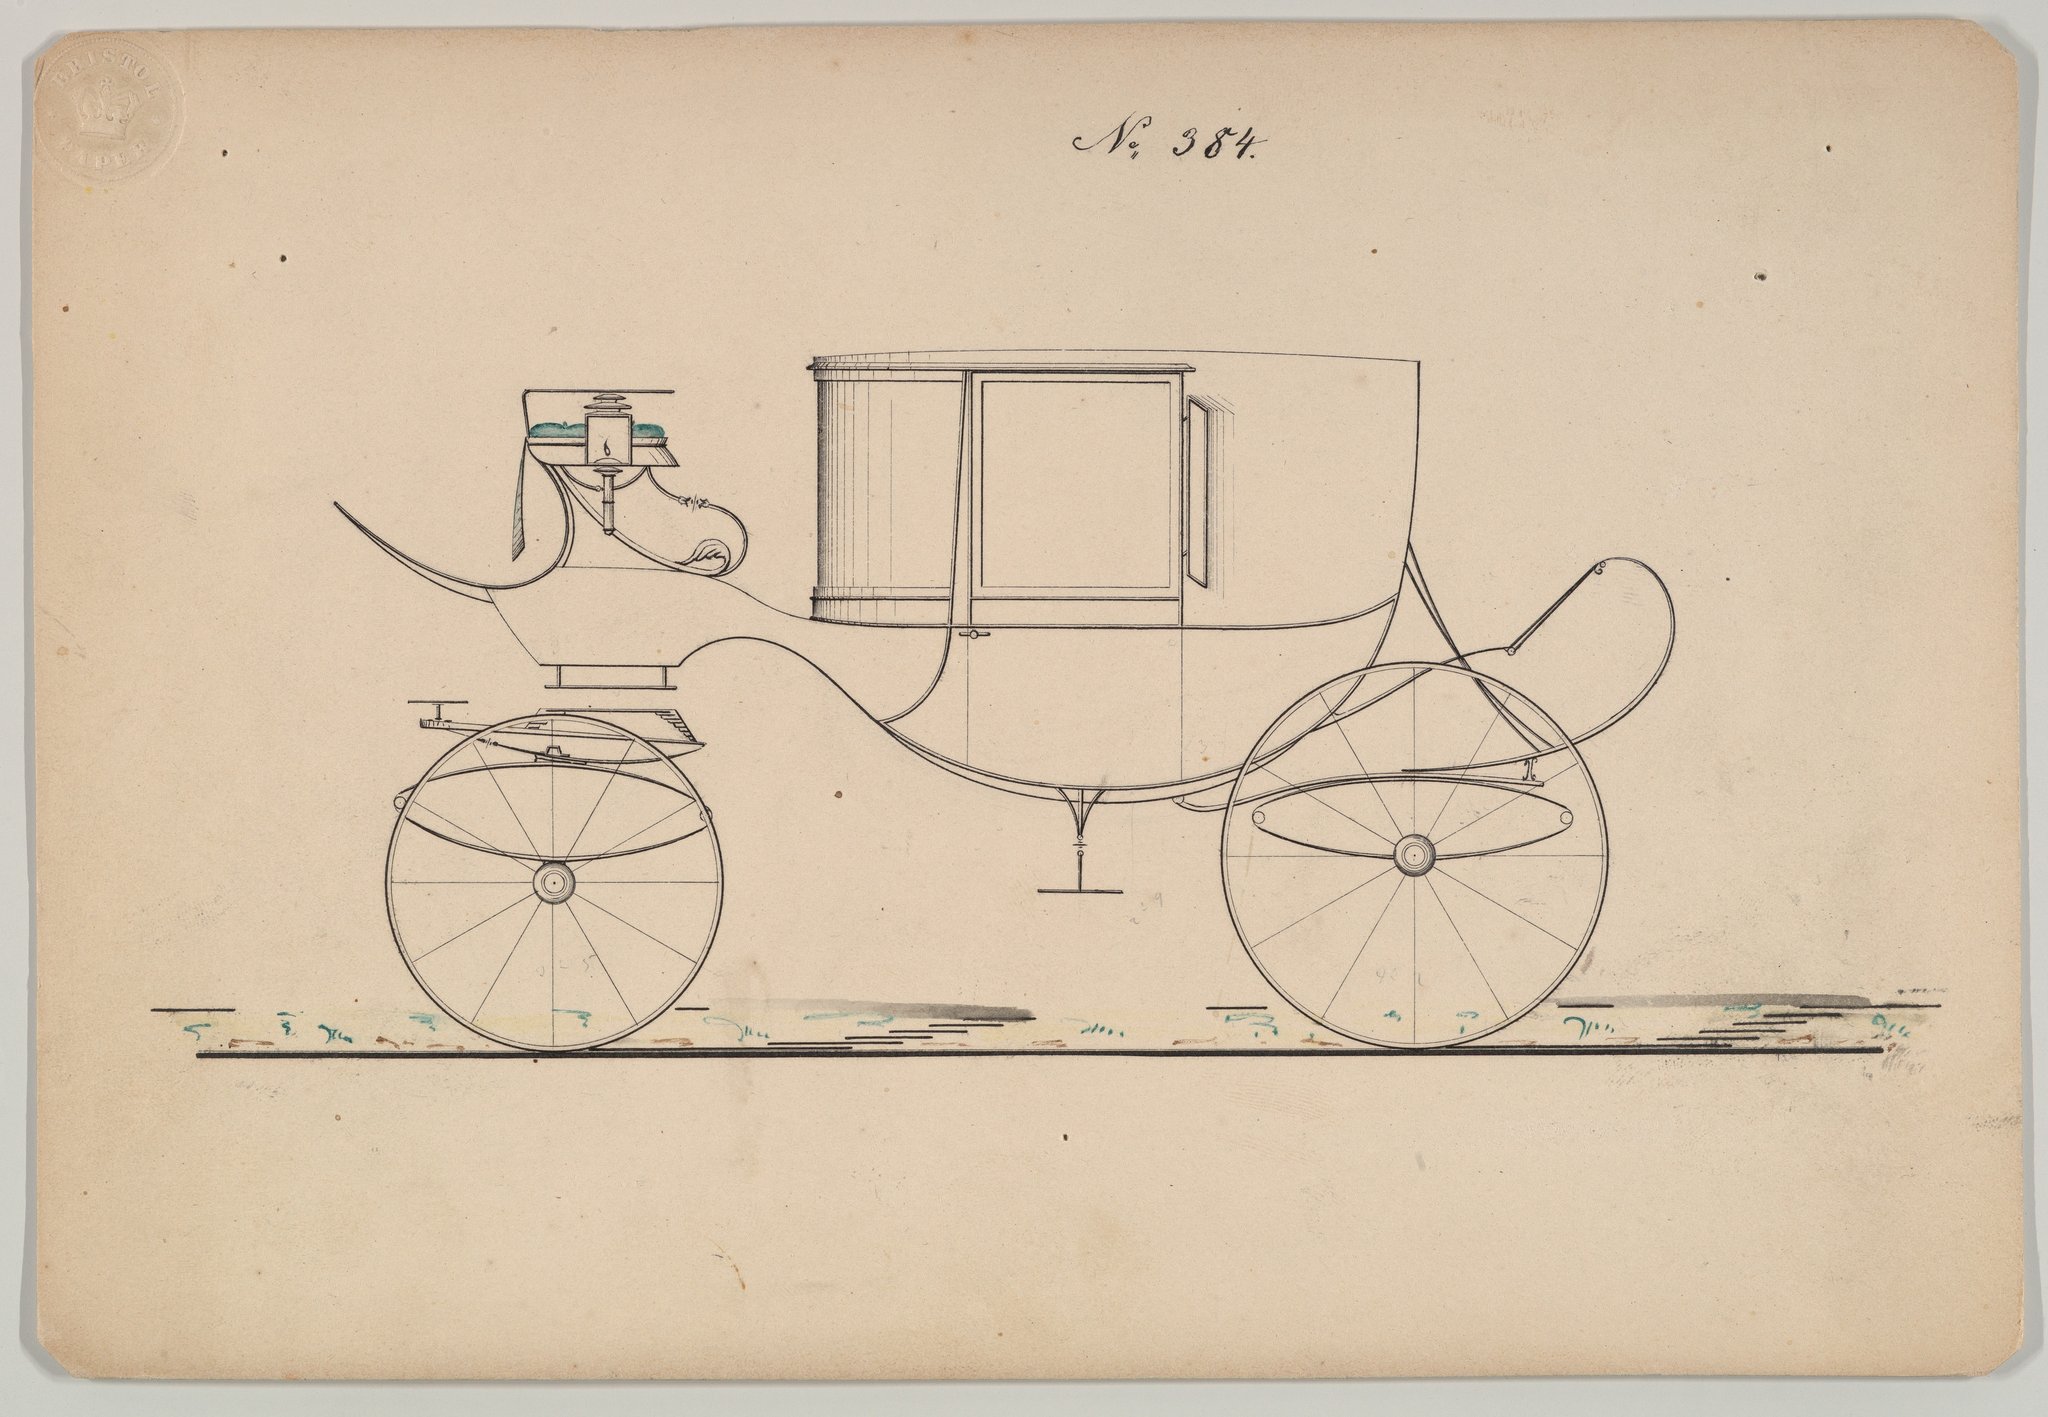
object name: drawing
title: Clarence #384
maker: brewster & co.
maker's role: manufacturer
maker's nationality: american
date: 1850-1870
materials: ink, watercolor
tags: carriages